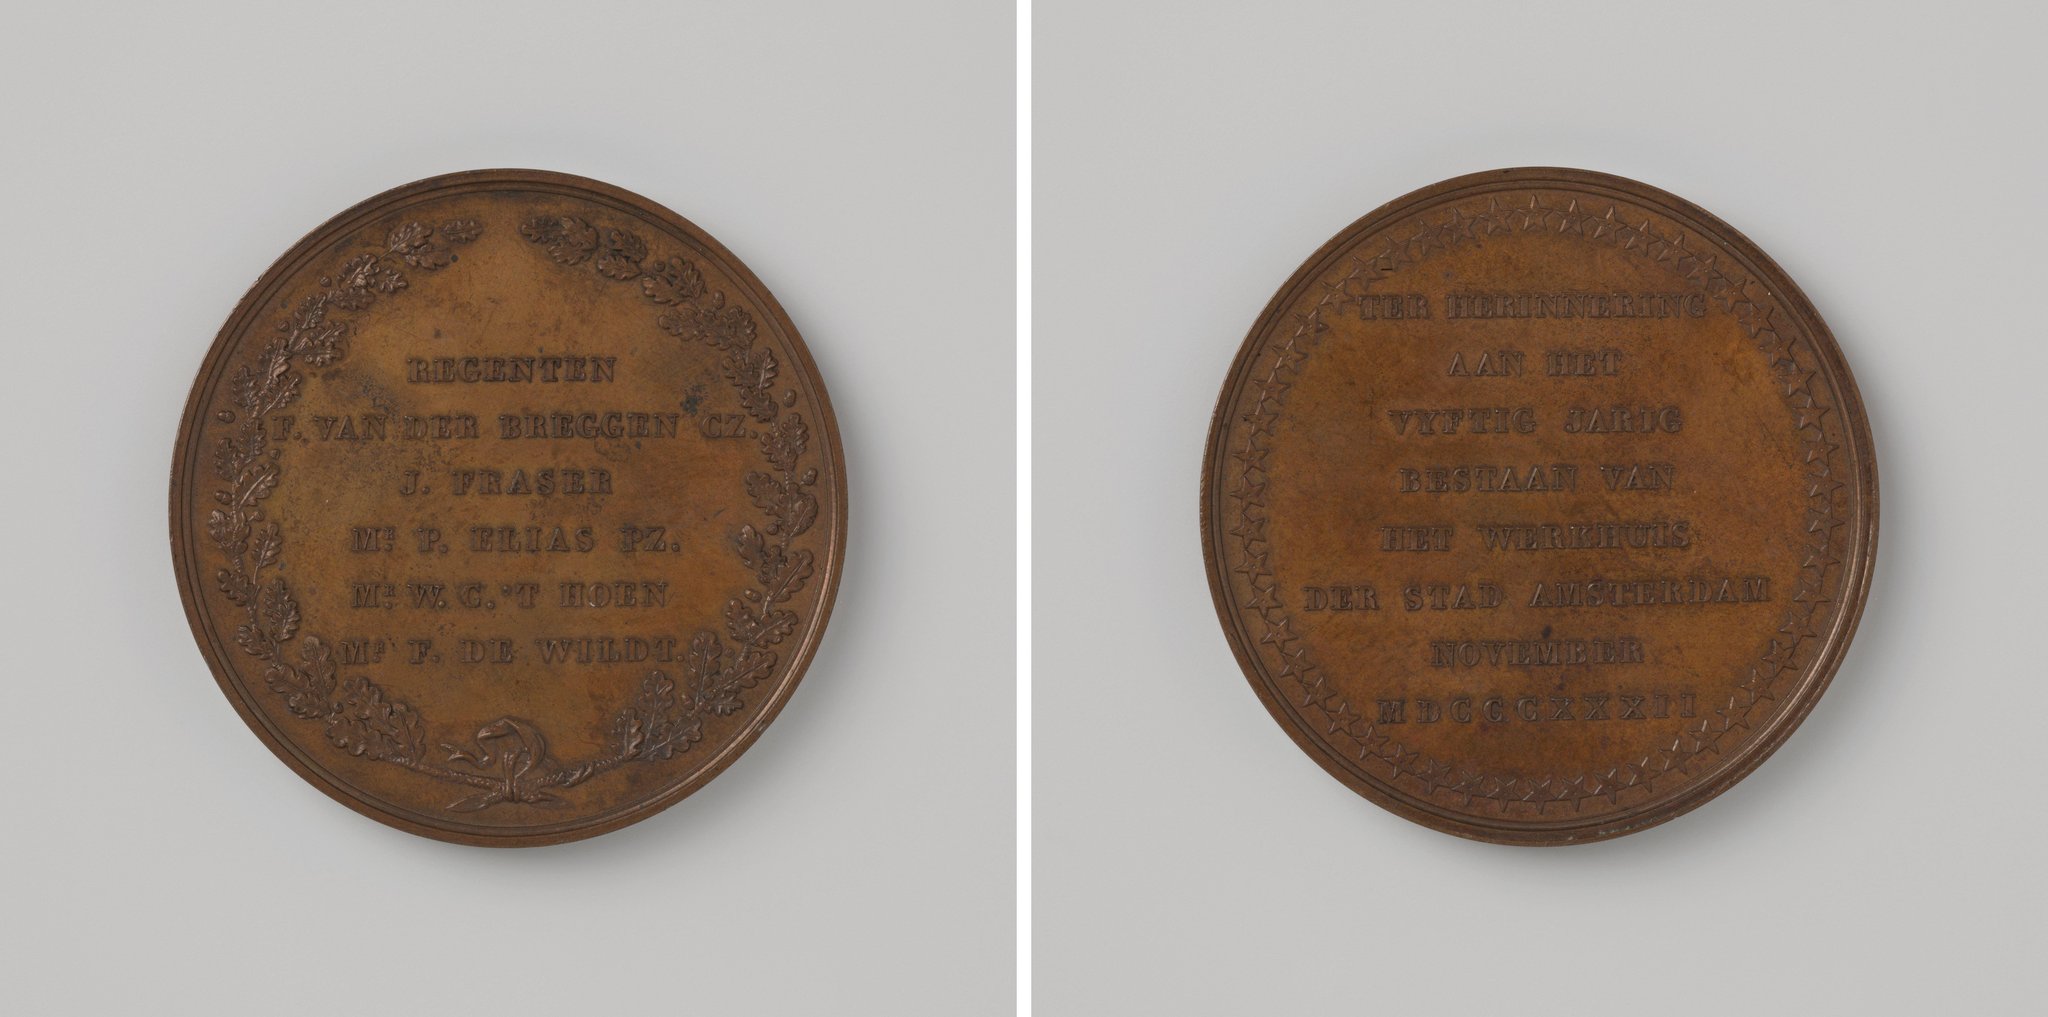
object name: history medal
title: Vijftigjarig bestaan van het Werkhuis te Amsterdam 1832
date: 1832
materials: bronze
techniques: striking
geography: utrecht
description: Bronzen penning, op de voorzijde acht regels tekst binnen een krans van vijftig sterren, op de keerzijde zes regels tekst tussen samengestrikte eikentakken.